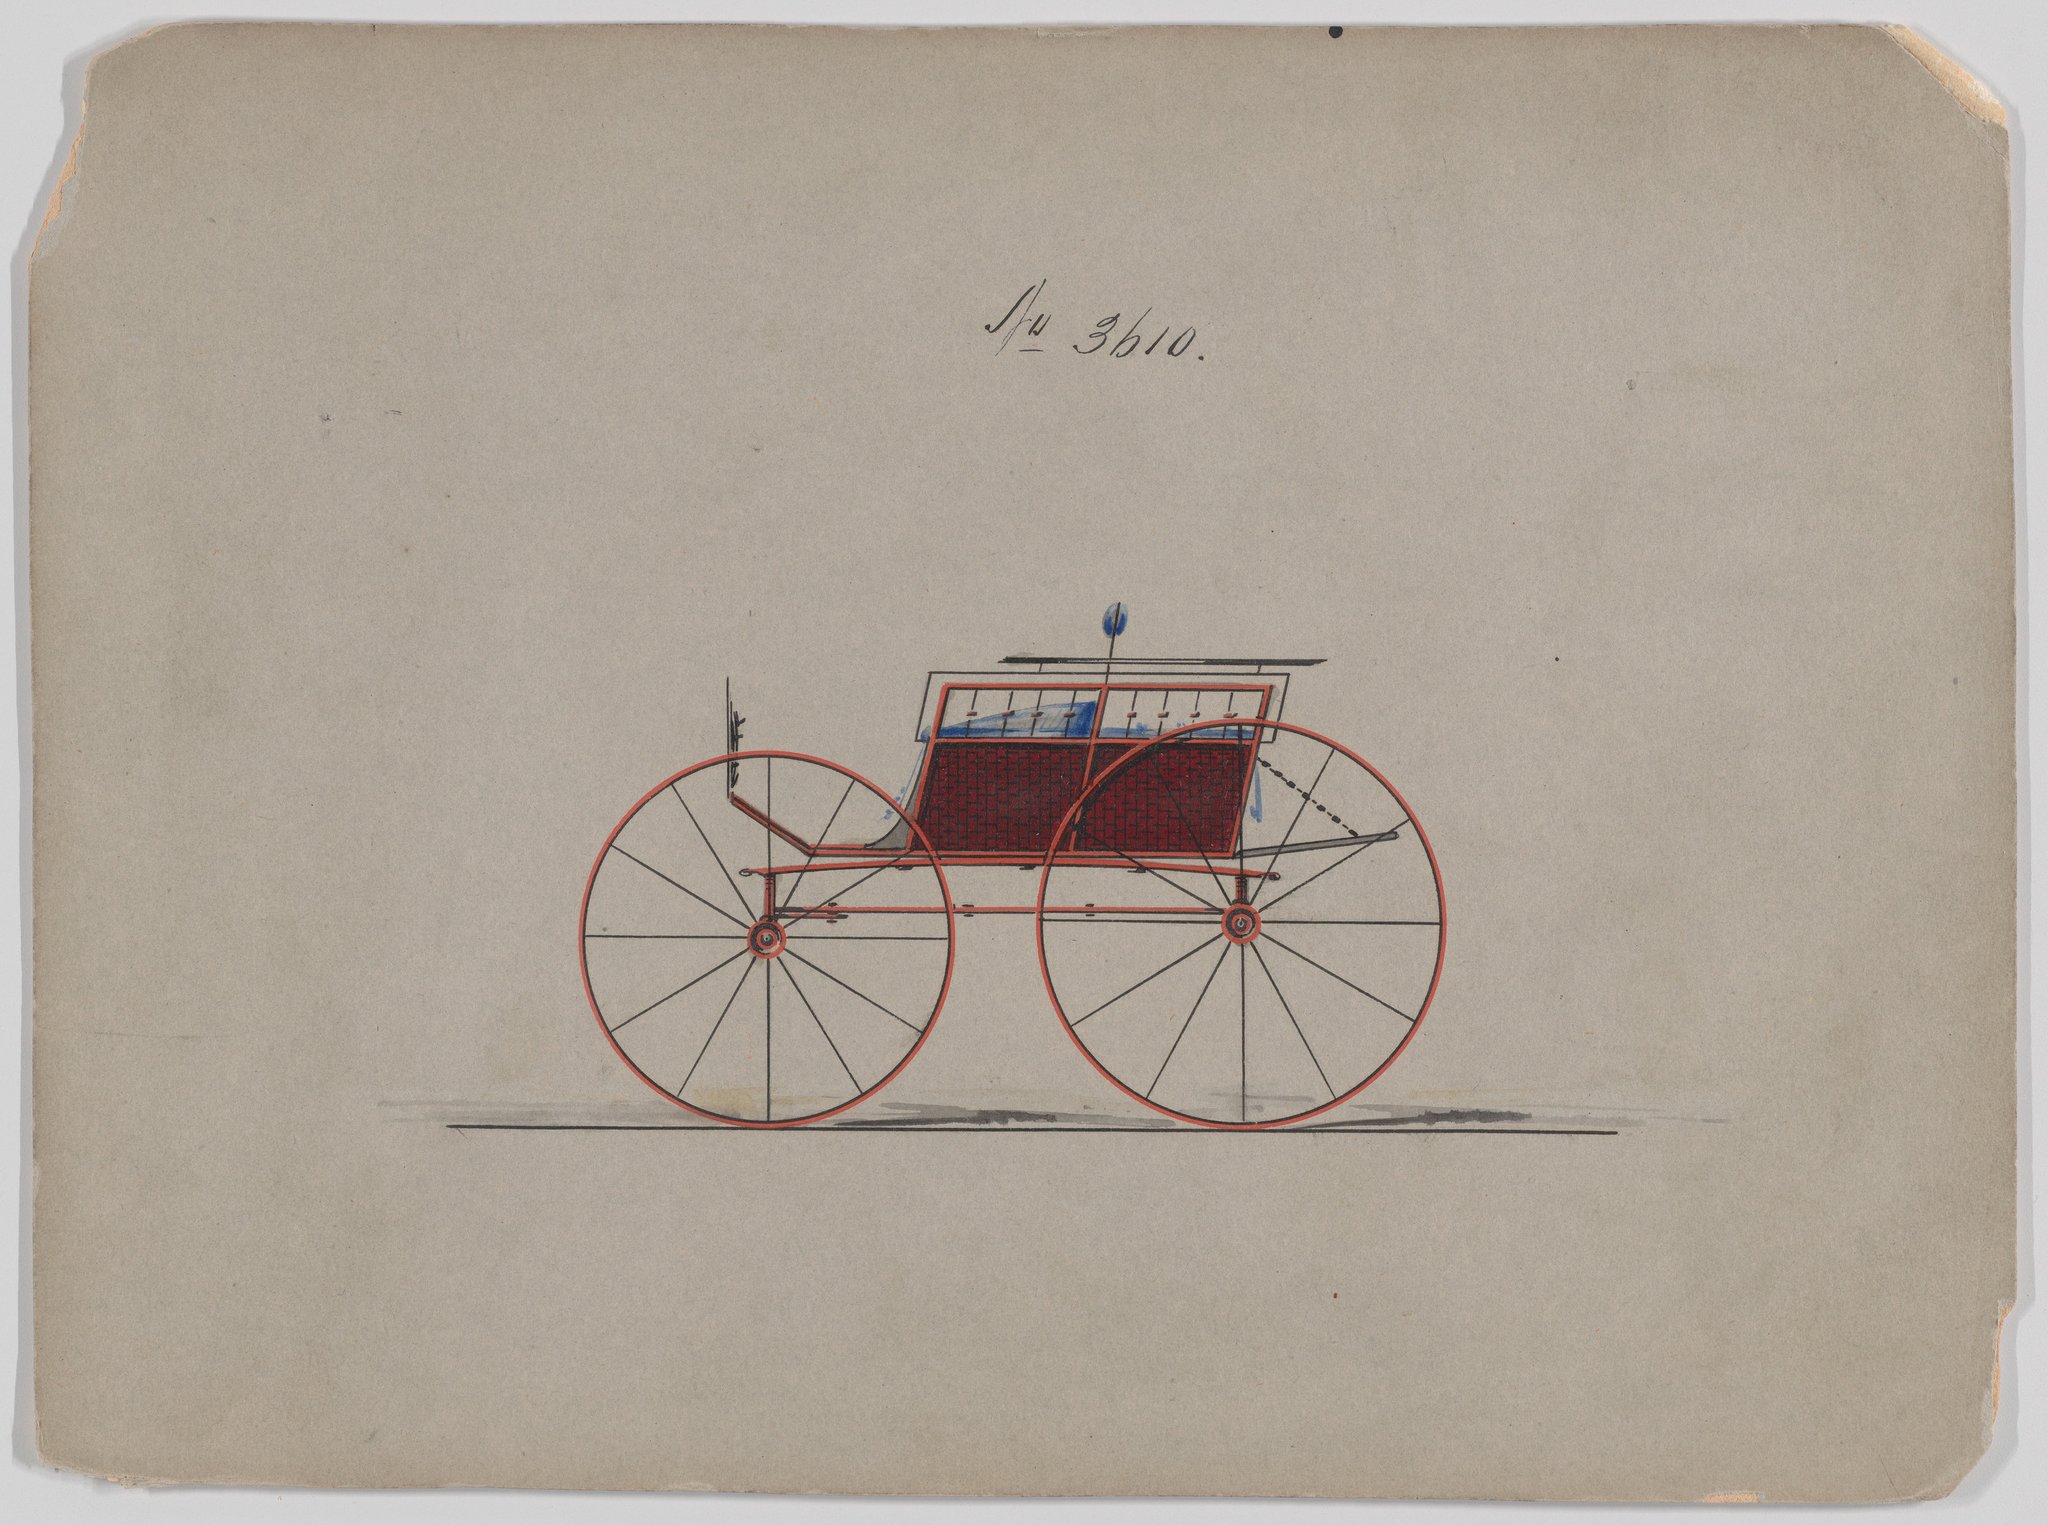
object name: drawing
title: Dos-a-dos Phaeton # 3610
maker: brewster & co.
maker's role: manufacturer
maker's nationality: american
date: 1880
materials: gouache, gum arabic, ink, watercolor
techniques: pen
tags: carriages